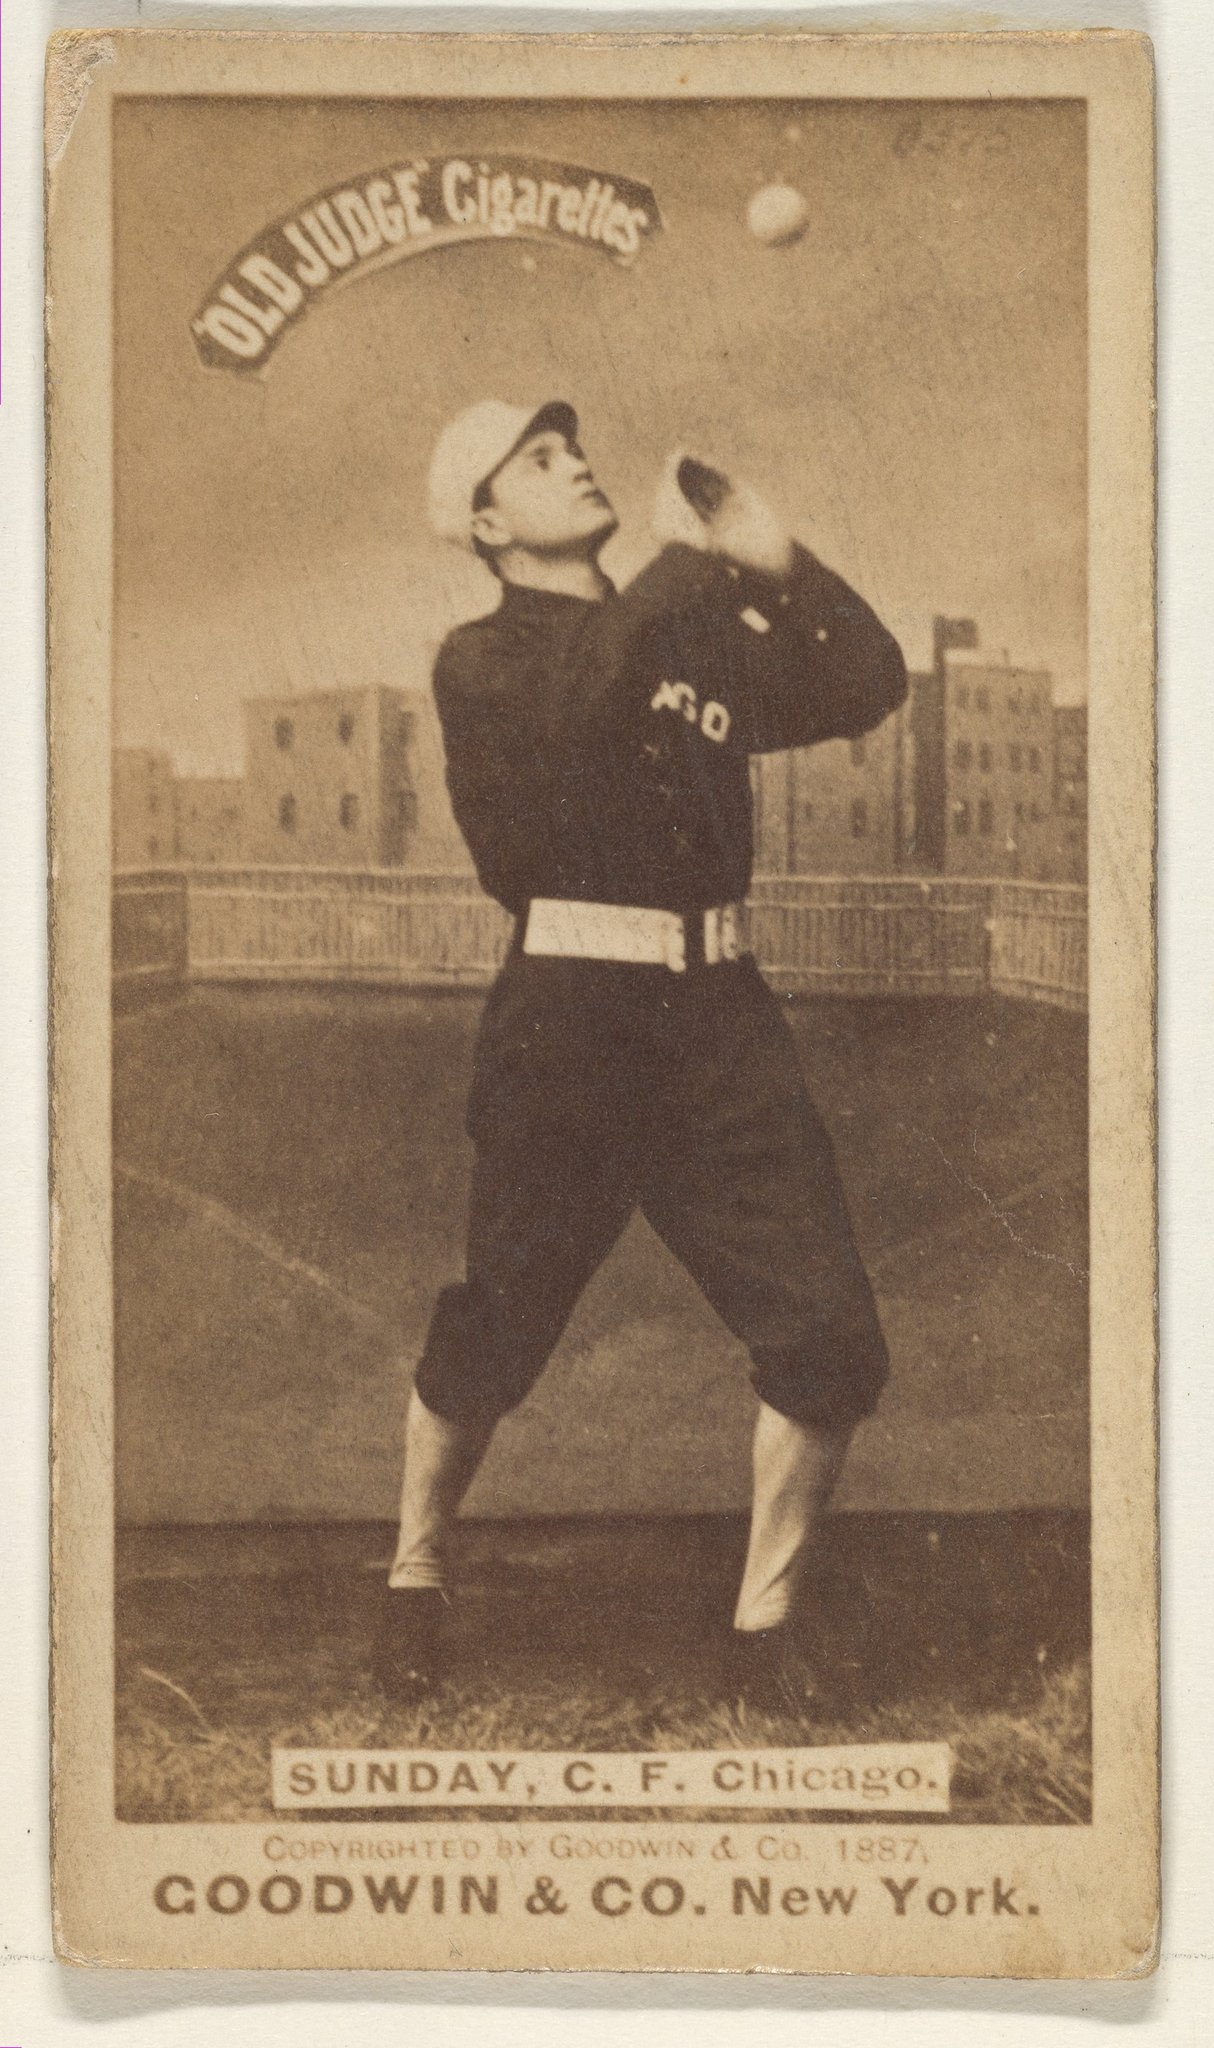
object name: baseball card, photograph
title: Sunday, Center Field, Chicago, from the Old Judge series (N172) for Old Judge Cigarettes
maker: goodwin & company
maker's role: publisher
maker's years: 1850-1950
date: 1887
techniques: albumen silver print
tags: men,portraits,baseball,athletes